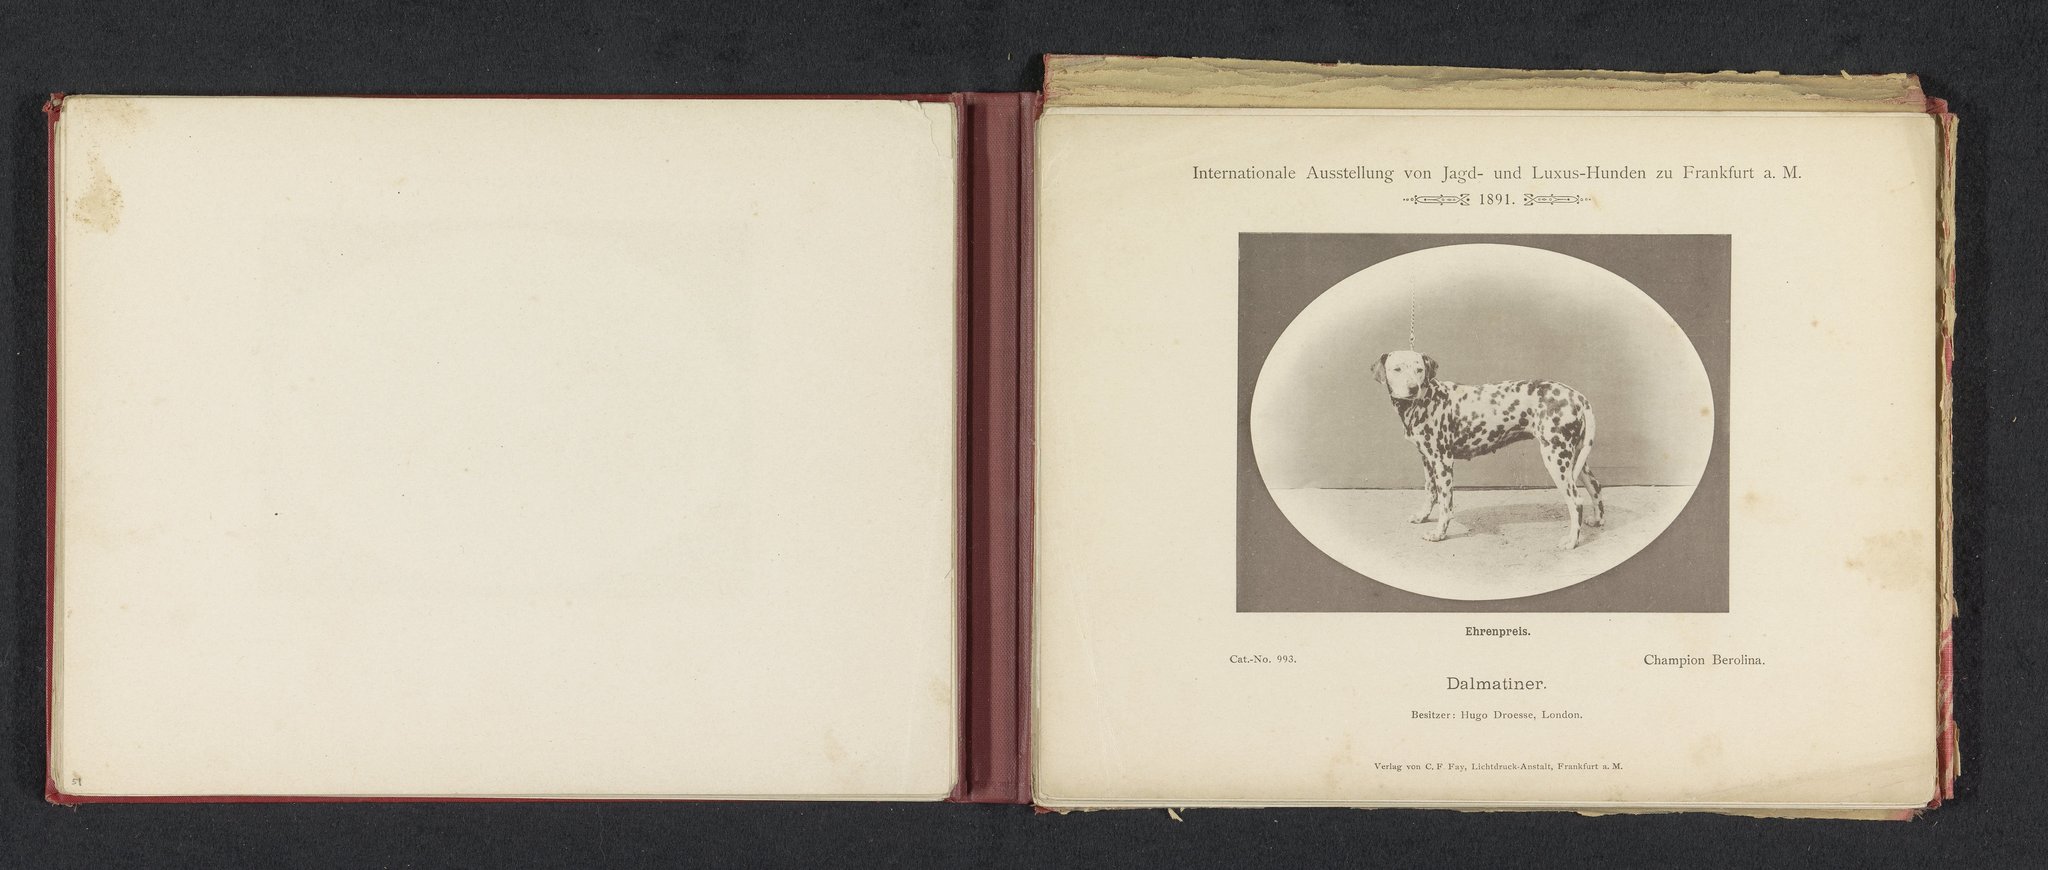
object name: page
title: Dalmatiër Champion Berolina die een ereprijs heeft gewonnen op de Internationale Ausstellung von Jagd und Luxus Hunden in 1891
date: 1891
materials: paper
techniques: photograph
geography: frankfurt am main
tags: dog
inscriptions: inscription: ‘Ehrenpreis. Champion Berolina. Besitzer : Hugo Droesse, London.’, number: ‘Cat.-No. 993.’